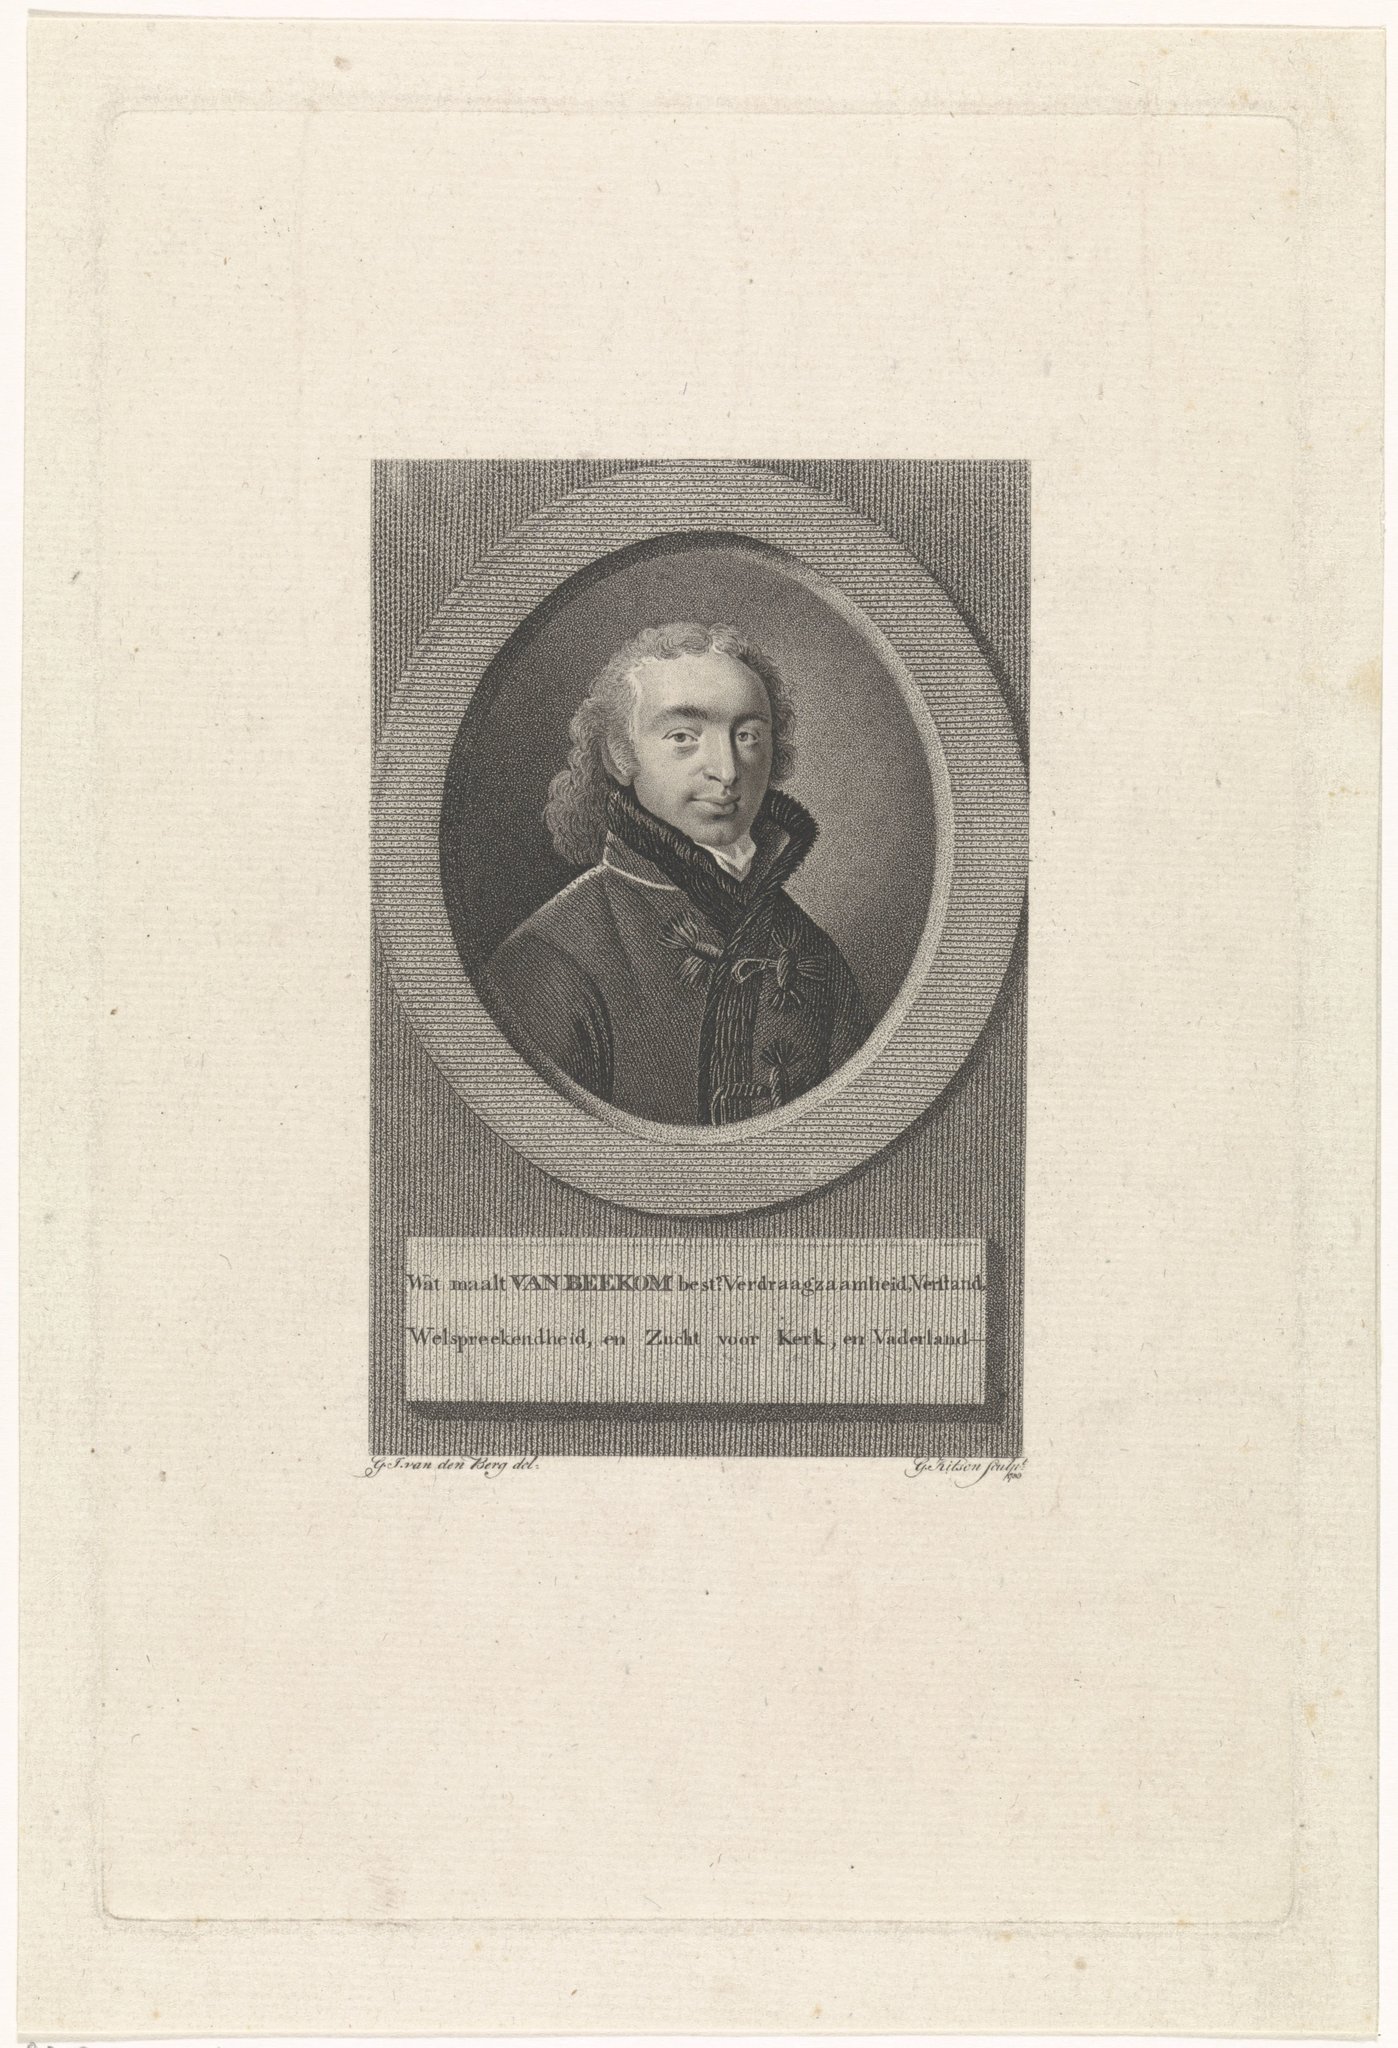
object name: print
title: Portret van Van Beekom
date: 1776-1810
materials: paper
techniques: aquatint, engraving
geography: rotterdam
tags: wig (+ sideview, profile)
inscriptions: collector's mark: Lugt 2228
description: Portretbuste van Van Beekom. Onder de ovale omlijsting een tweeregelige Nederlandse tekst.